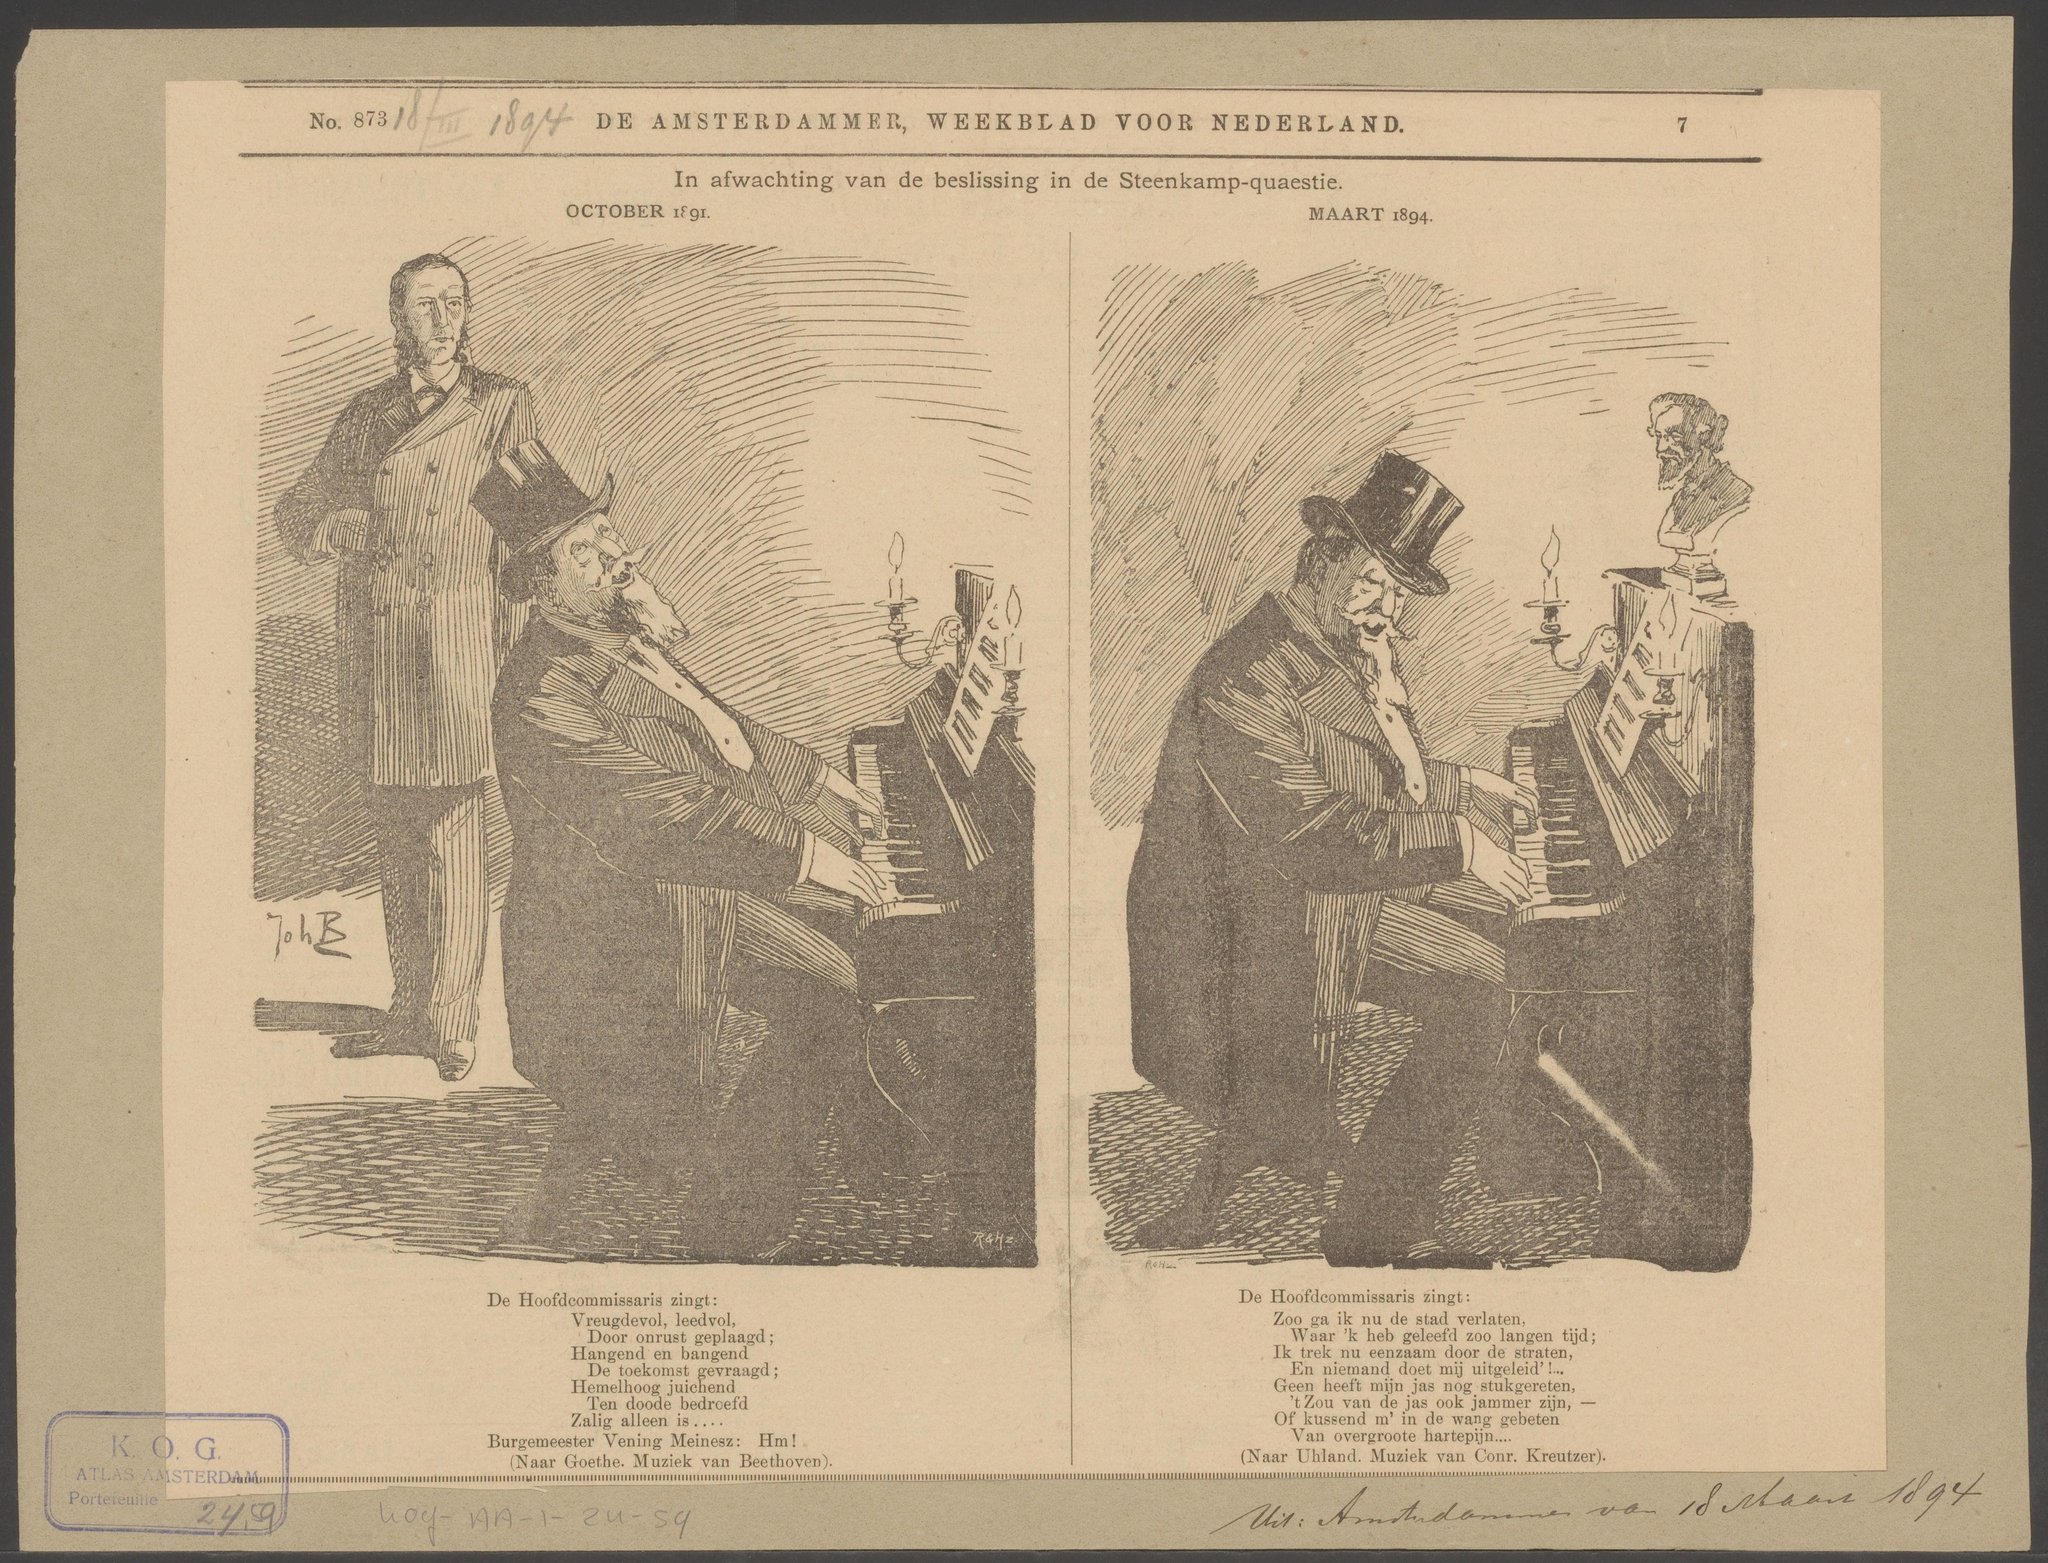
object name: cartoon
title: In afwachting van de beslissing in de Steenkamp-quaestie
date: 1894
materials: paper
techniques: letterpress printing, line block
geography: amsterdam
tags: politician, vocal music, singing, pianoforte, political caricatures and satires, amsterdam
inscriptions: collector's mark: Lugt 1641b, signature: ‘R&Hz.’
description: Prent uit: De Amsterdammer 18 (1894), nr. 873, 18 maart 1894, p. 7.